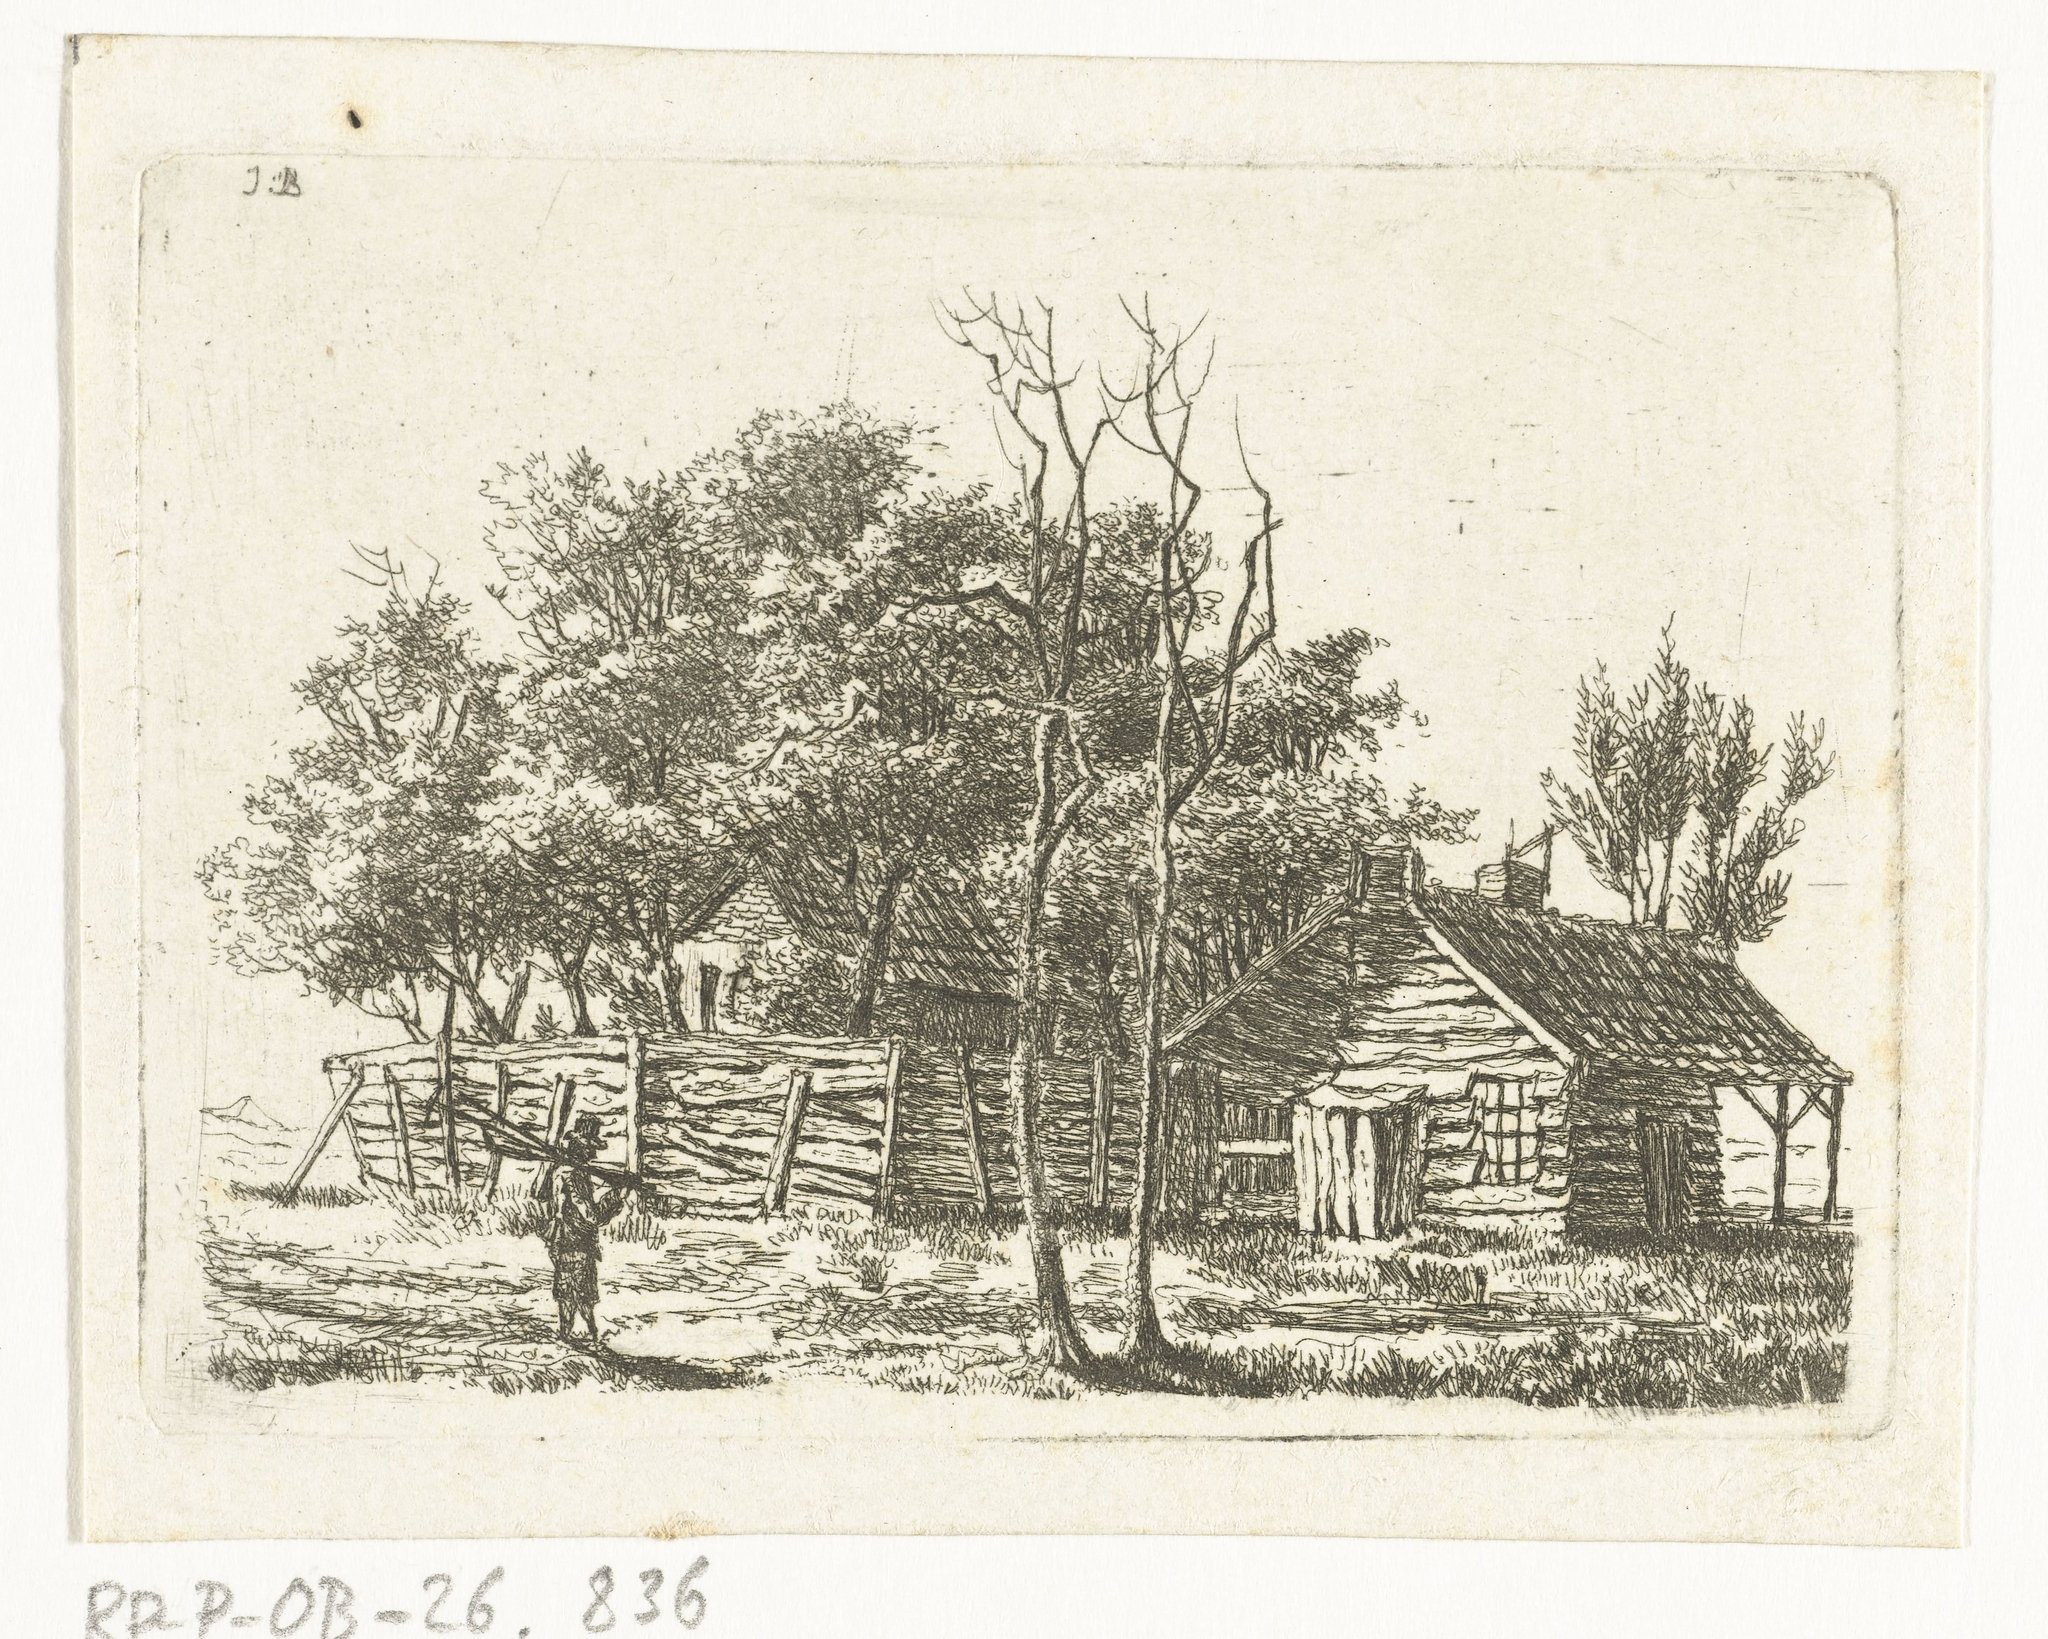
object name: print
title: IJskelder bij de Utrechtse Poort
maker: johannes ludovicus van den bos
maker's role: draughtsman, print maker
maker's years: 1800-1827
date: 1815-1827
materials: paper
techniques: etching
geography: amsterdam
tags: ice-cellar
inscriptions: collector's mark: Lugt 2228